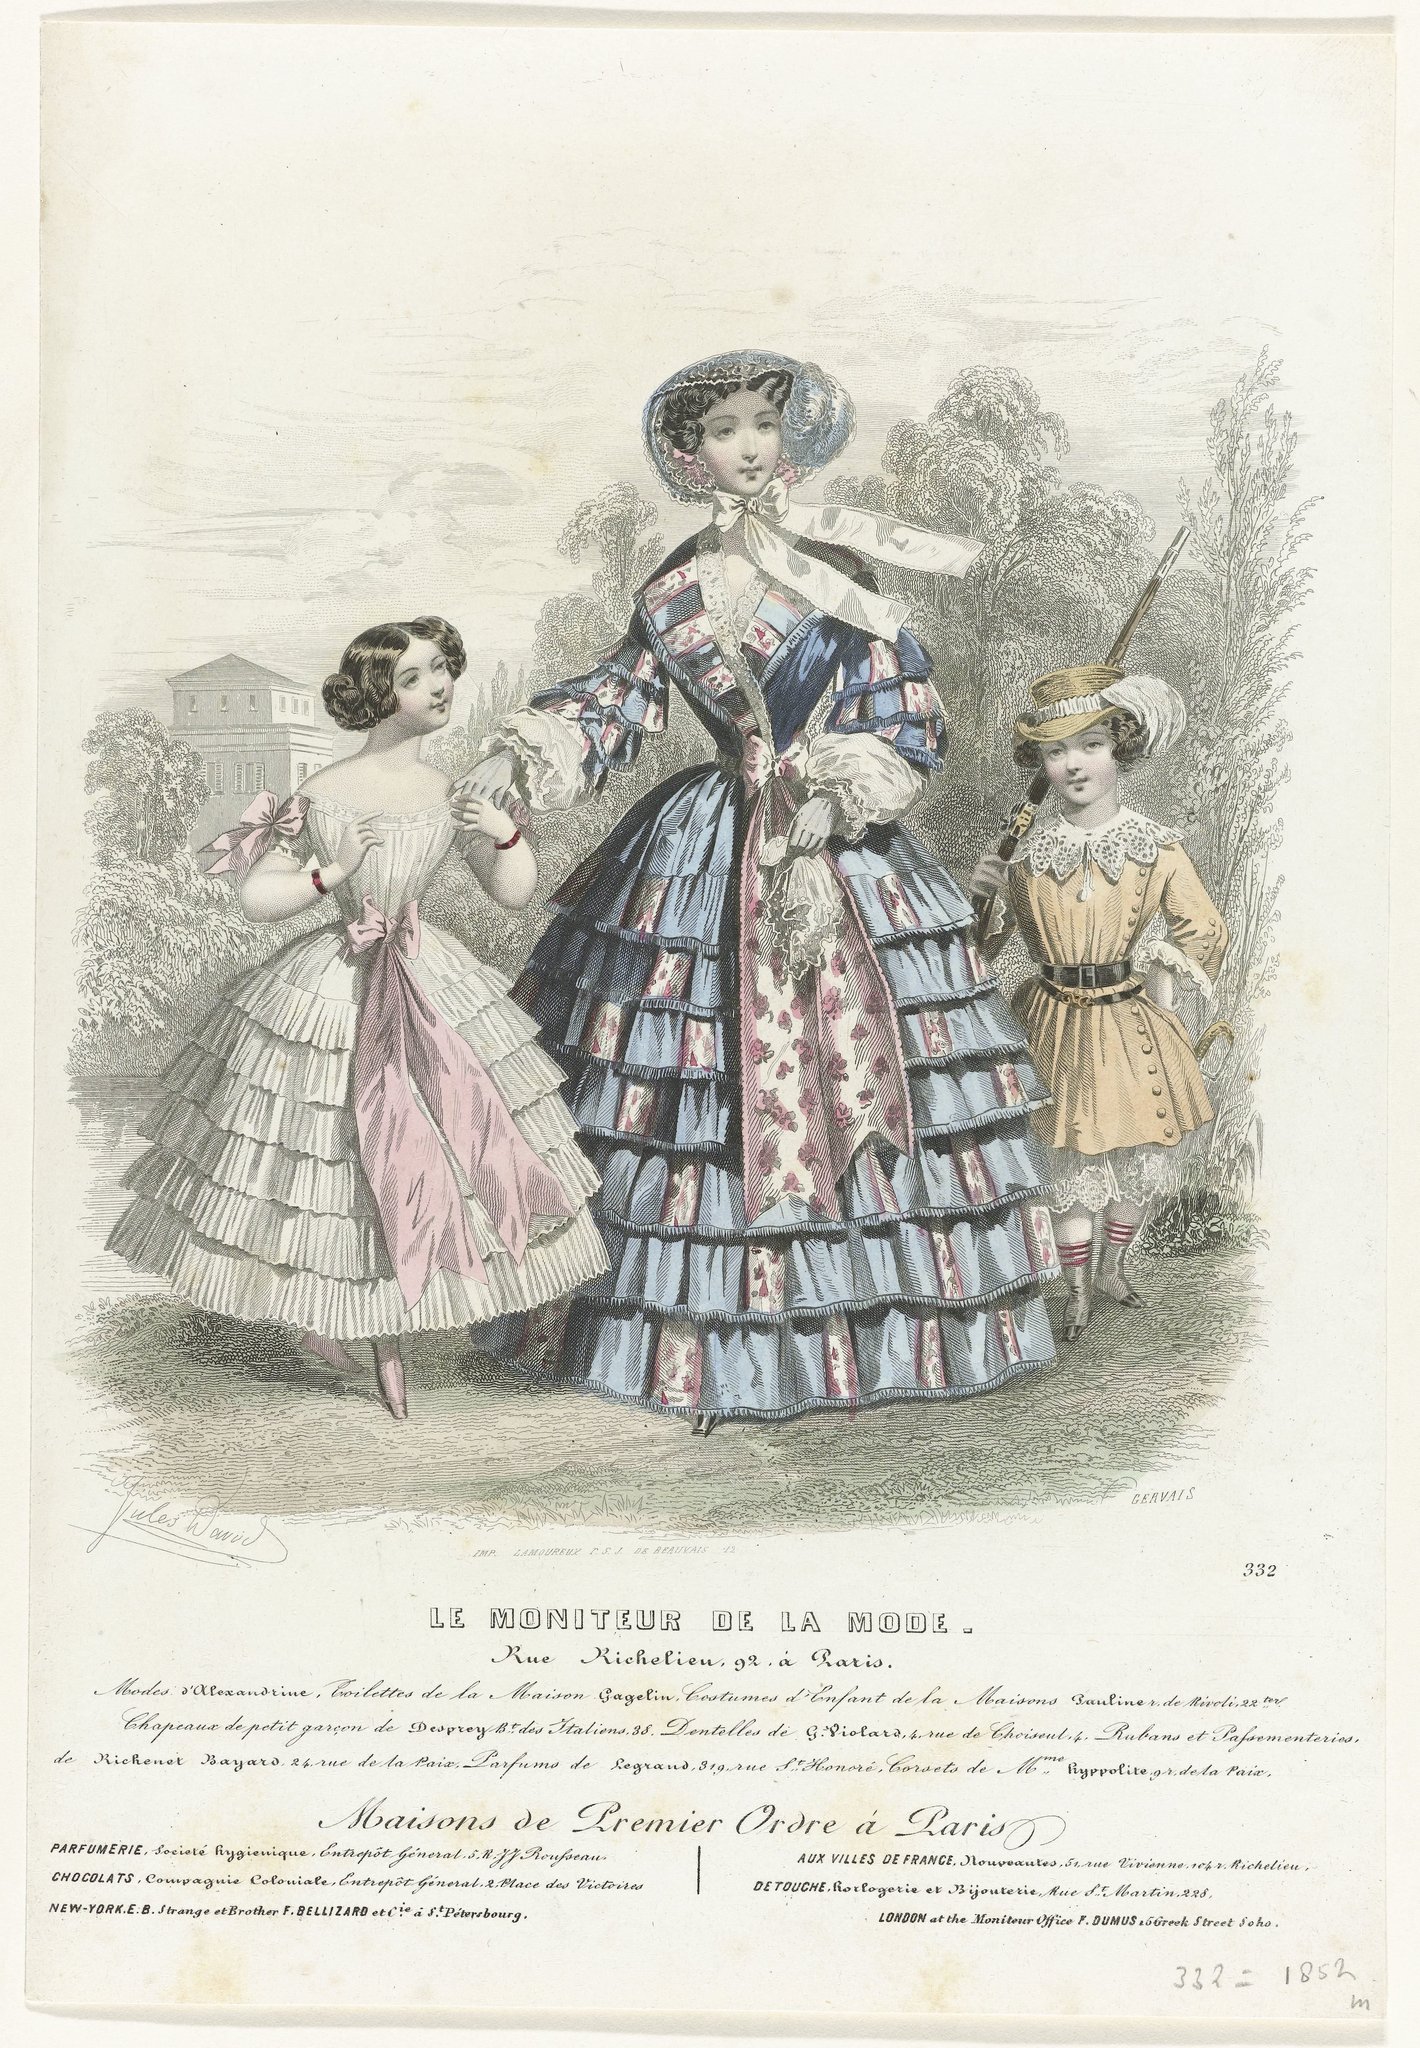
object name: fashion print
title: Le Moniteur de la Mode, 1852, No. 332 : Modes d'Alexandrin (...)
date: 1852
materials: paper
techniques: engraving, hand coloring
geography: paris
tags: handkerchief (+ women's clothes), clothes, costume (+ girls' clothes), ornamental parts of clothing (+ women's clothes), lace (+ women's clothes), head-gear (+ boys' clothes), clothes, costume (+ boys' clothes), fashion plates, head-gear: hat (+ women's clothes), gloves, mittens, etc. (+ women's clothes), belt, girdle, waistband (+ women's clothes)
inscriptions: caption: ‘Modes d'Alexandrine, Toilettes de la maison Gagelin, Costumes d'Enfant de la Maisons Pauline r. de Ricoli, 22"ter. chapeaux de petit garçon de Desprey B"t des Italiens, 38. Dentelles de G. Violard, 4, rue de Choiseul, 4. Rubans et Passementeries, de Richenet Bayard, 24, rue de la Paix, Parfums de Legrand, 319, rue S"t Honoré, Corsets de M"me Hyppolite, 9, r. de la Paix.’, title: ‘Le Moniteur de la Mode.’, address: ‘Rue Richelieu, 92, à Paris.’, address: ‘New-York. E.B. Strange et Brother, F. Bellizard et C.ie à S.t Pétersbourg. / London at the Moniteur Office. F. Dumus 15 Greek Street Soho.’, caption: ‘Maisons de premier ordre à Paris / Parfumerie, Societé Hygienique, Entrepôt Général 5 R JJ Rousseau / Chocolats, Compagnie Coloniale, Entrepôt Général, 2, Place des Victoires / Aux Villes de France, Nouveautes, 51, rue Vivienne, 104, r. Richelieu, Detouche, horlogerie et Bijouterie, rue S"t Martin, 228.’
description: Een vrouw en twee kinderen in de buitenlucht, op de achtergrond een landgoed. Volgens het onderschrift: 'modes' van Alexandrine. 'Toilettes' van Maison Gagelin. Kinderkleding van de firma Pauline. Hieronder enkele regels reclametekst voor verschillende producten. Prent uit het modetijdschrift Le Moniteur de la mode (1843-1913).